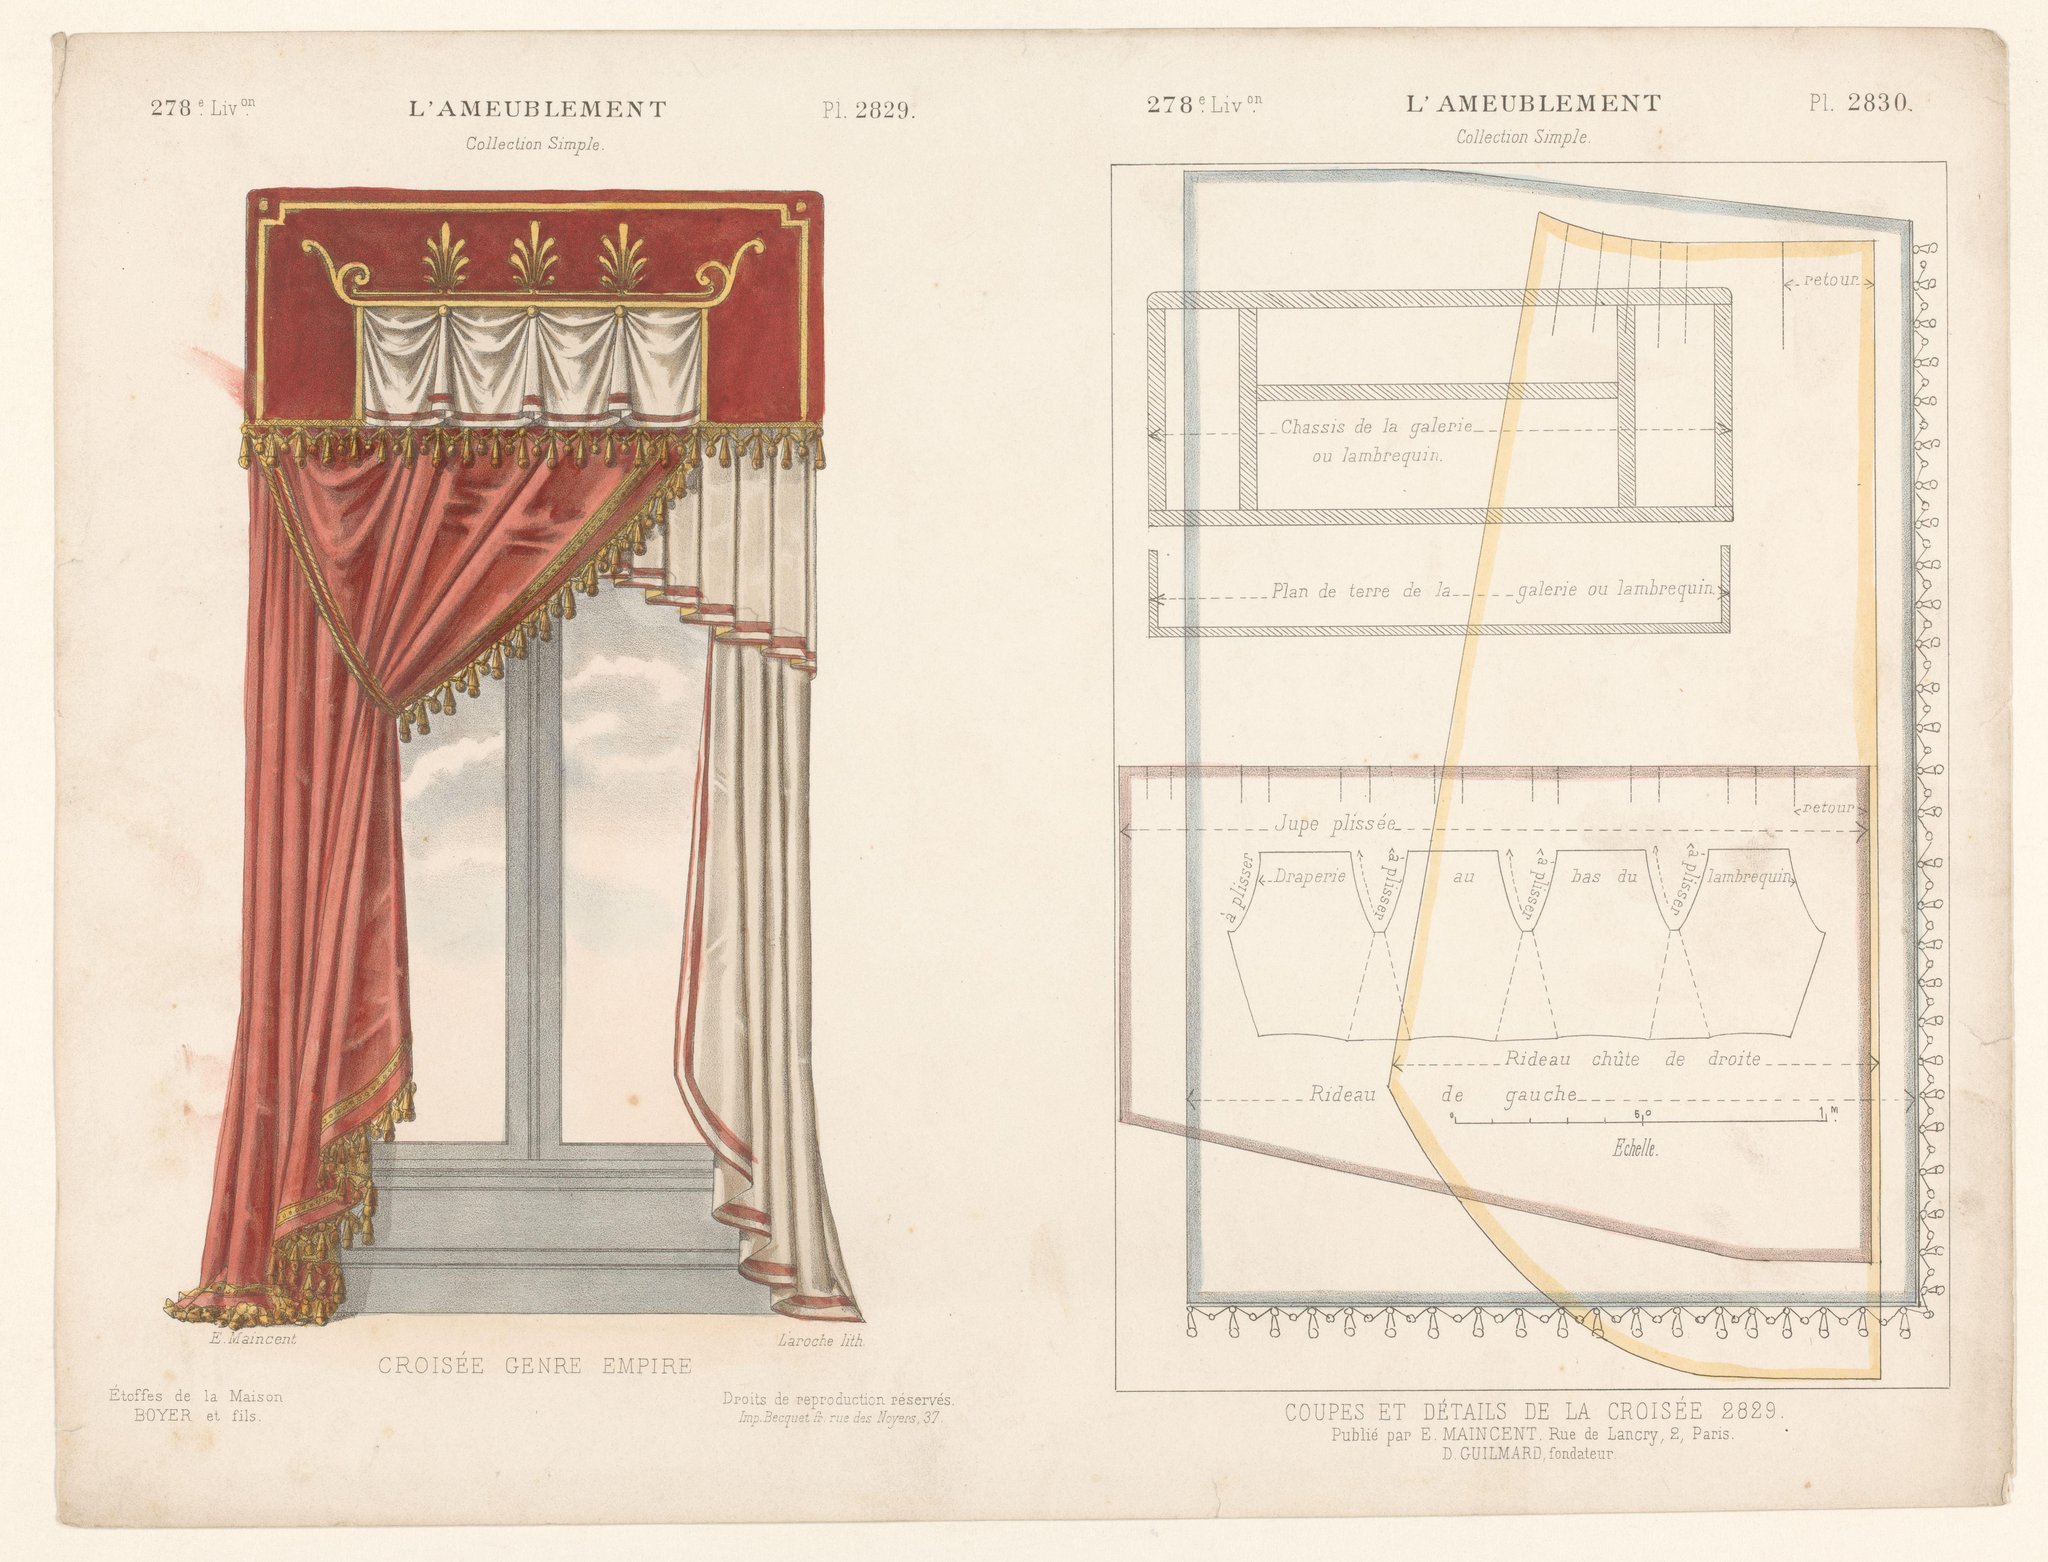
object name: print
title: L'ameublement / Collection simple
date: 1885-1895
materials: paper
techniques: hand coloring, lithograph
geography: paris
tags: window, hangings and drapery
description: Een venster met gedrapeerde gordijnen. Rechts details van de draperieën. Prent uit 278e Livraison.